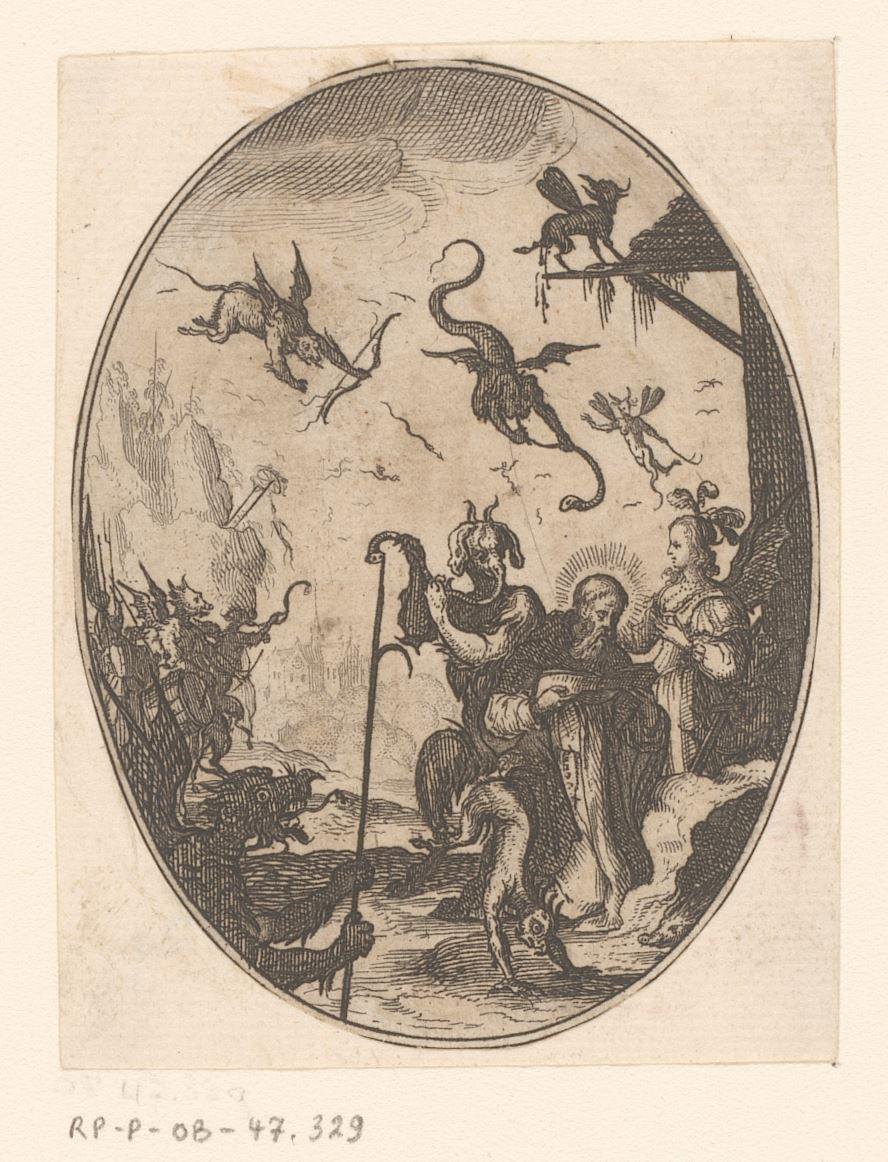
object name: print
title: Verleiding van H. Antonius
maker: nicolas cochin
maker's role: print maker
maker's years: 1610-1686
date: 1620-1686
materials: paper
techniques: engraving, etching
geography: france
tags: male saints (with name) - temptation of male saint, devil(s) and demons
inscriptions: collector's mark: Lugt 240